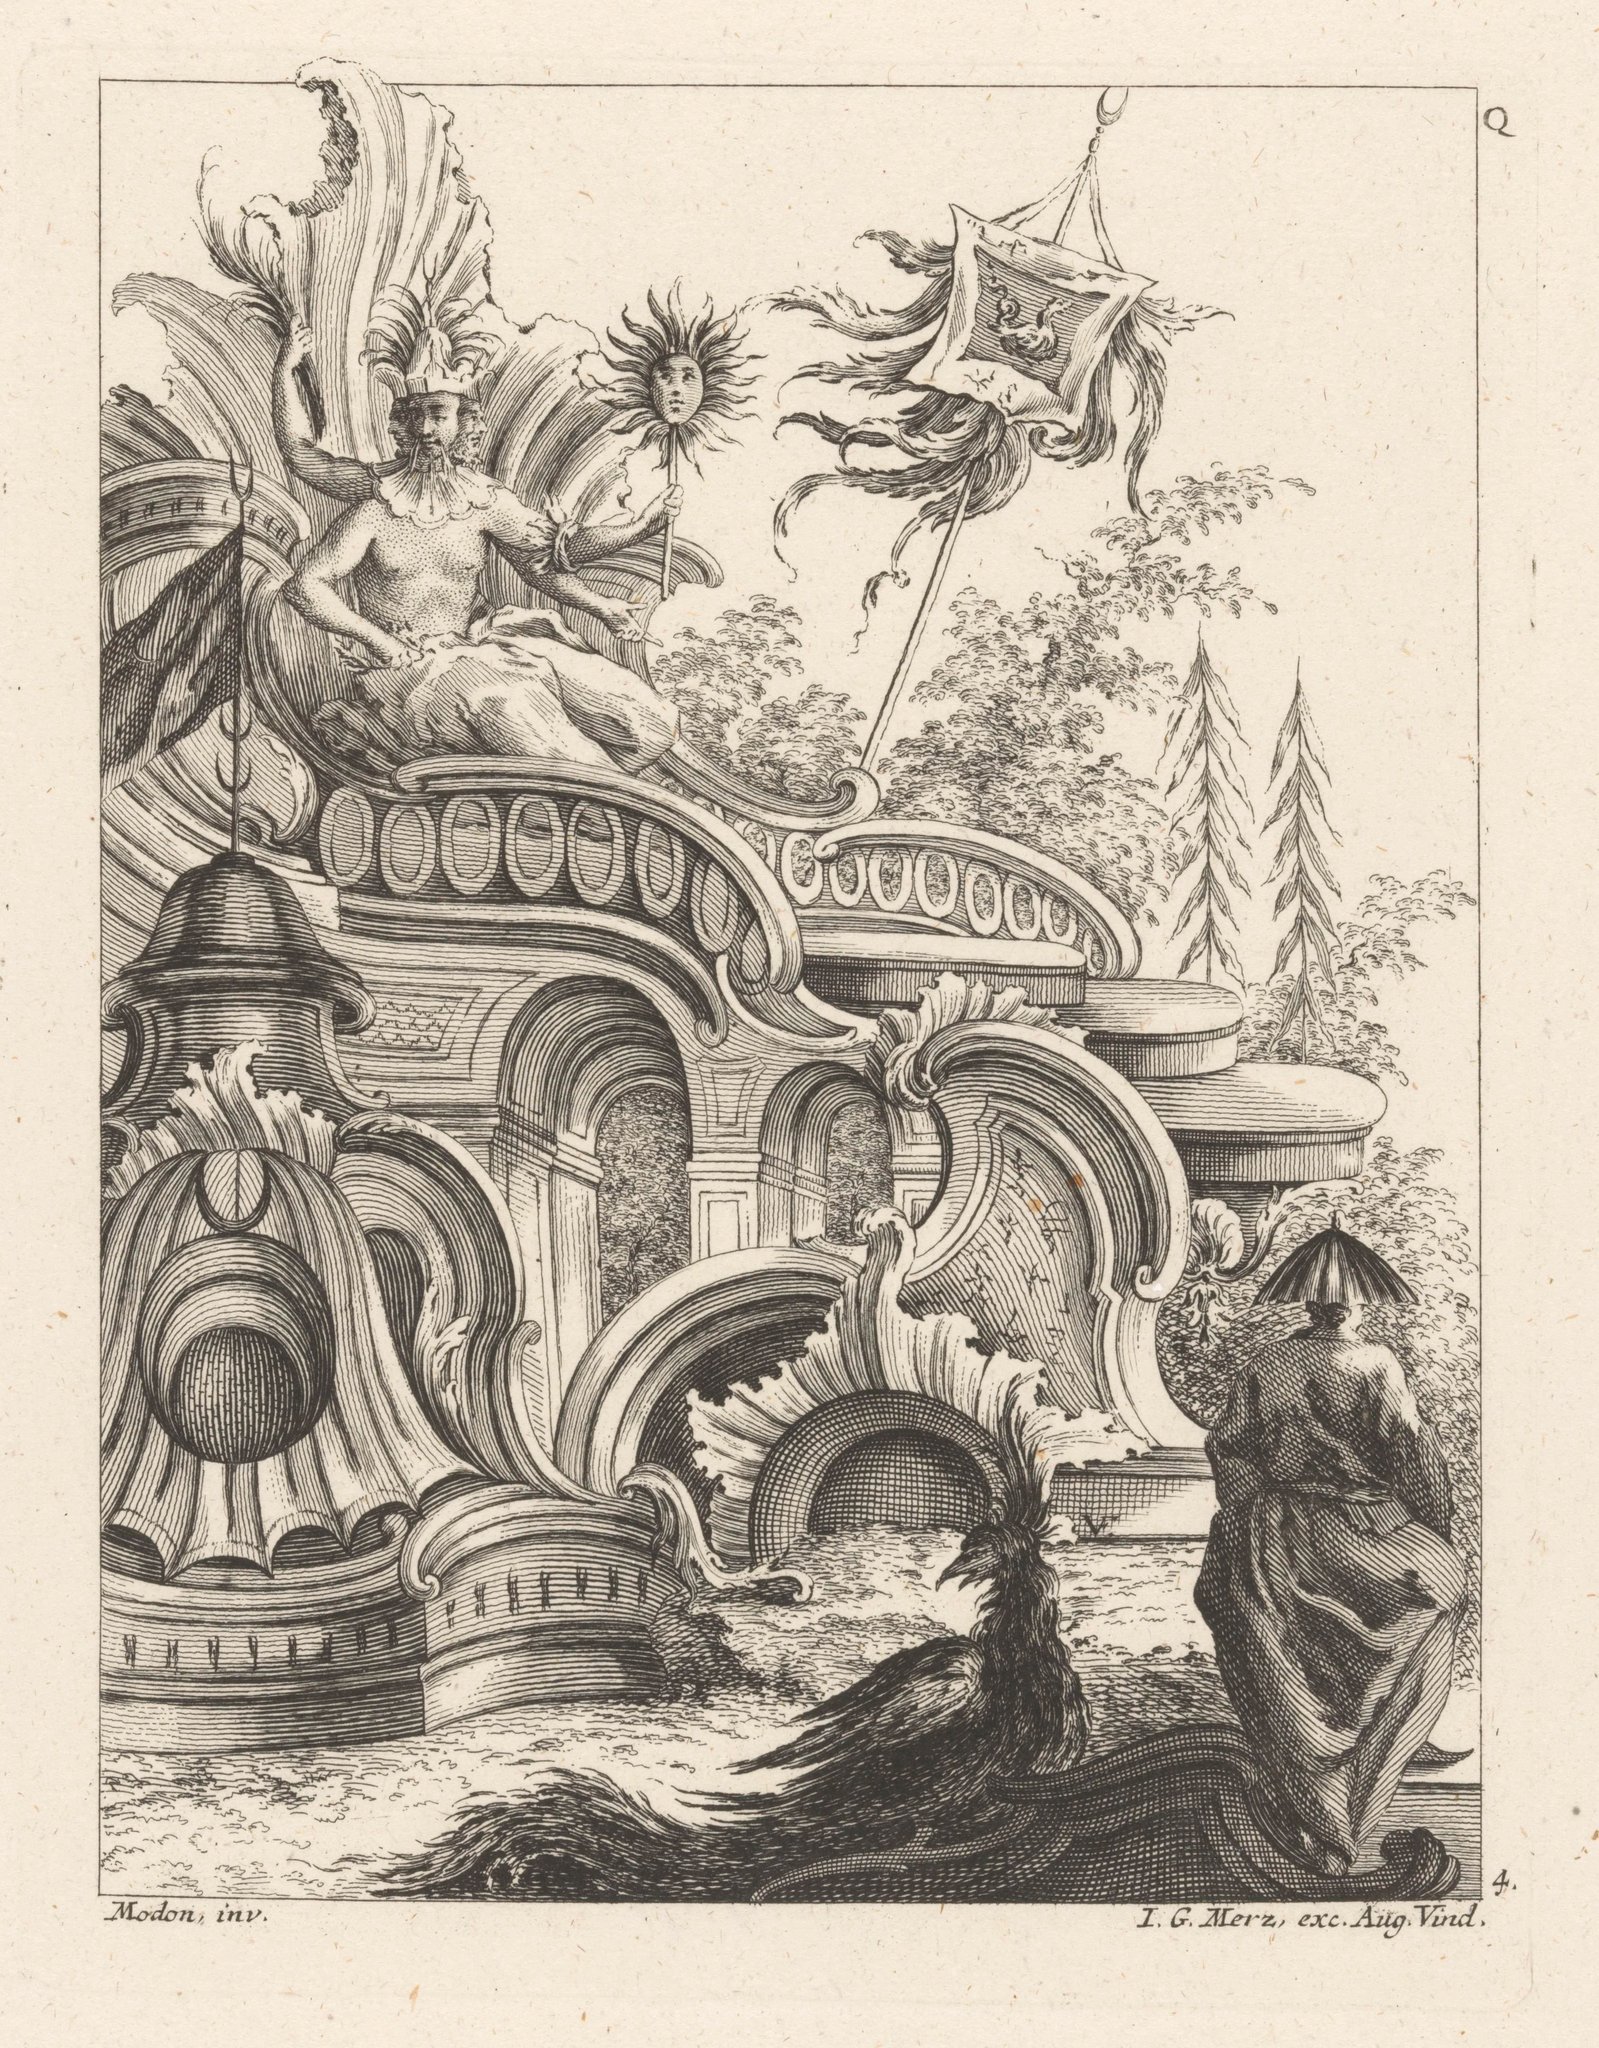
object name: ornament print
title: God met drie gezichten op troon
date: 1736-1762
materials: paper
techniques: etching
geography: augsburg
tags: three-faced being, 'vultus trifrons', throne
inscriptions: collector's mark: Lugt 2228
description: Een god met drie gezichten en vier armen zit op een rocaille troon, hij houdt een staf met de zon vast. Naast hem een vlag met een draak. Rechts op de voorgrond staan een draak en een oosterse figuur naast water.